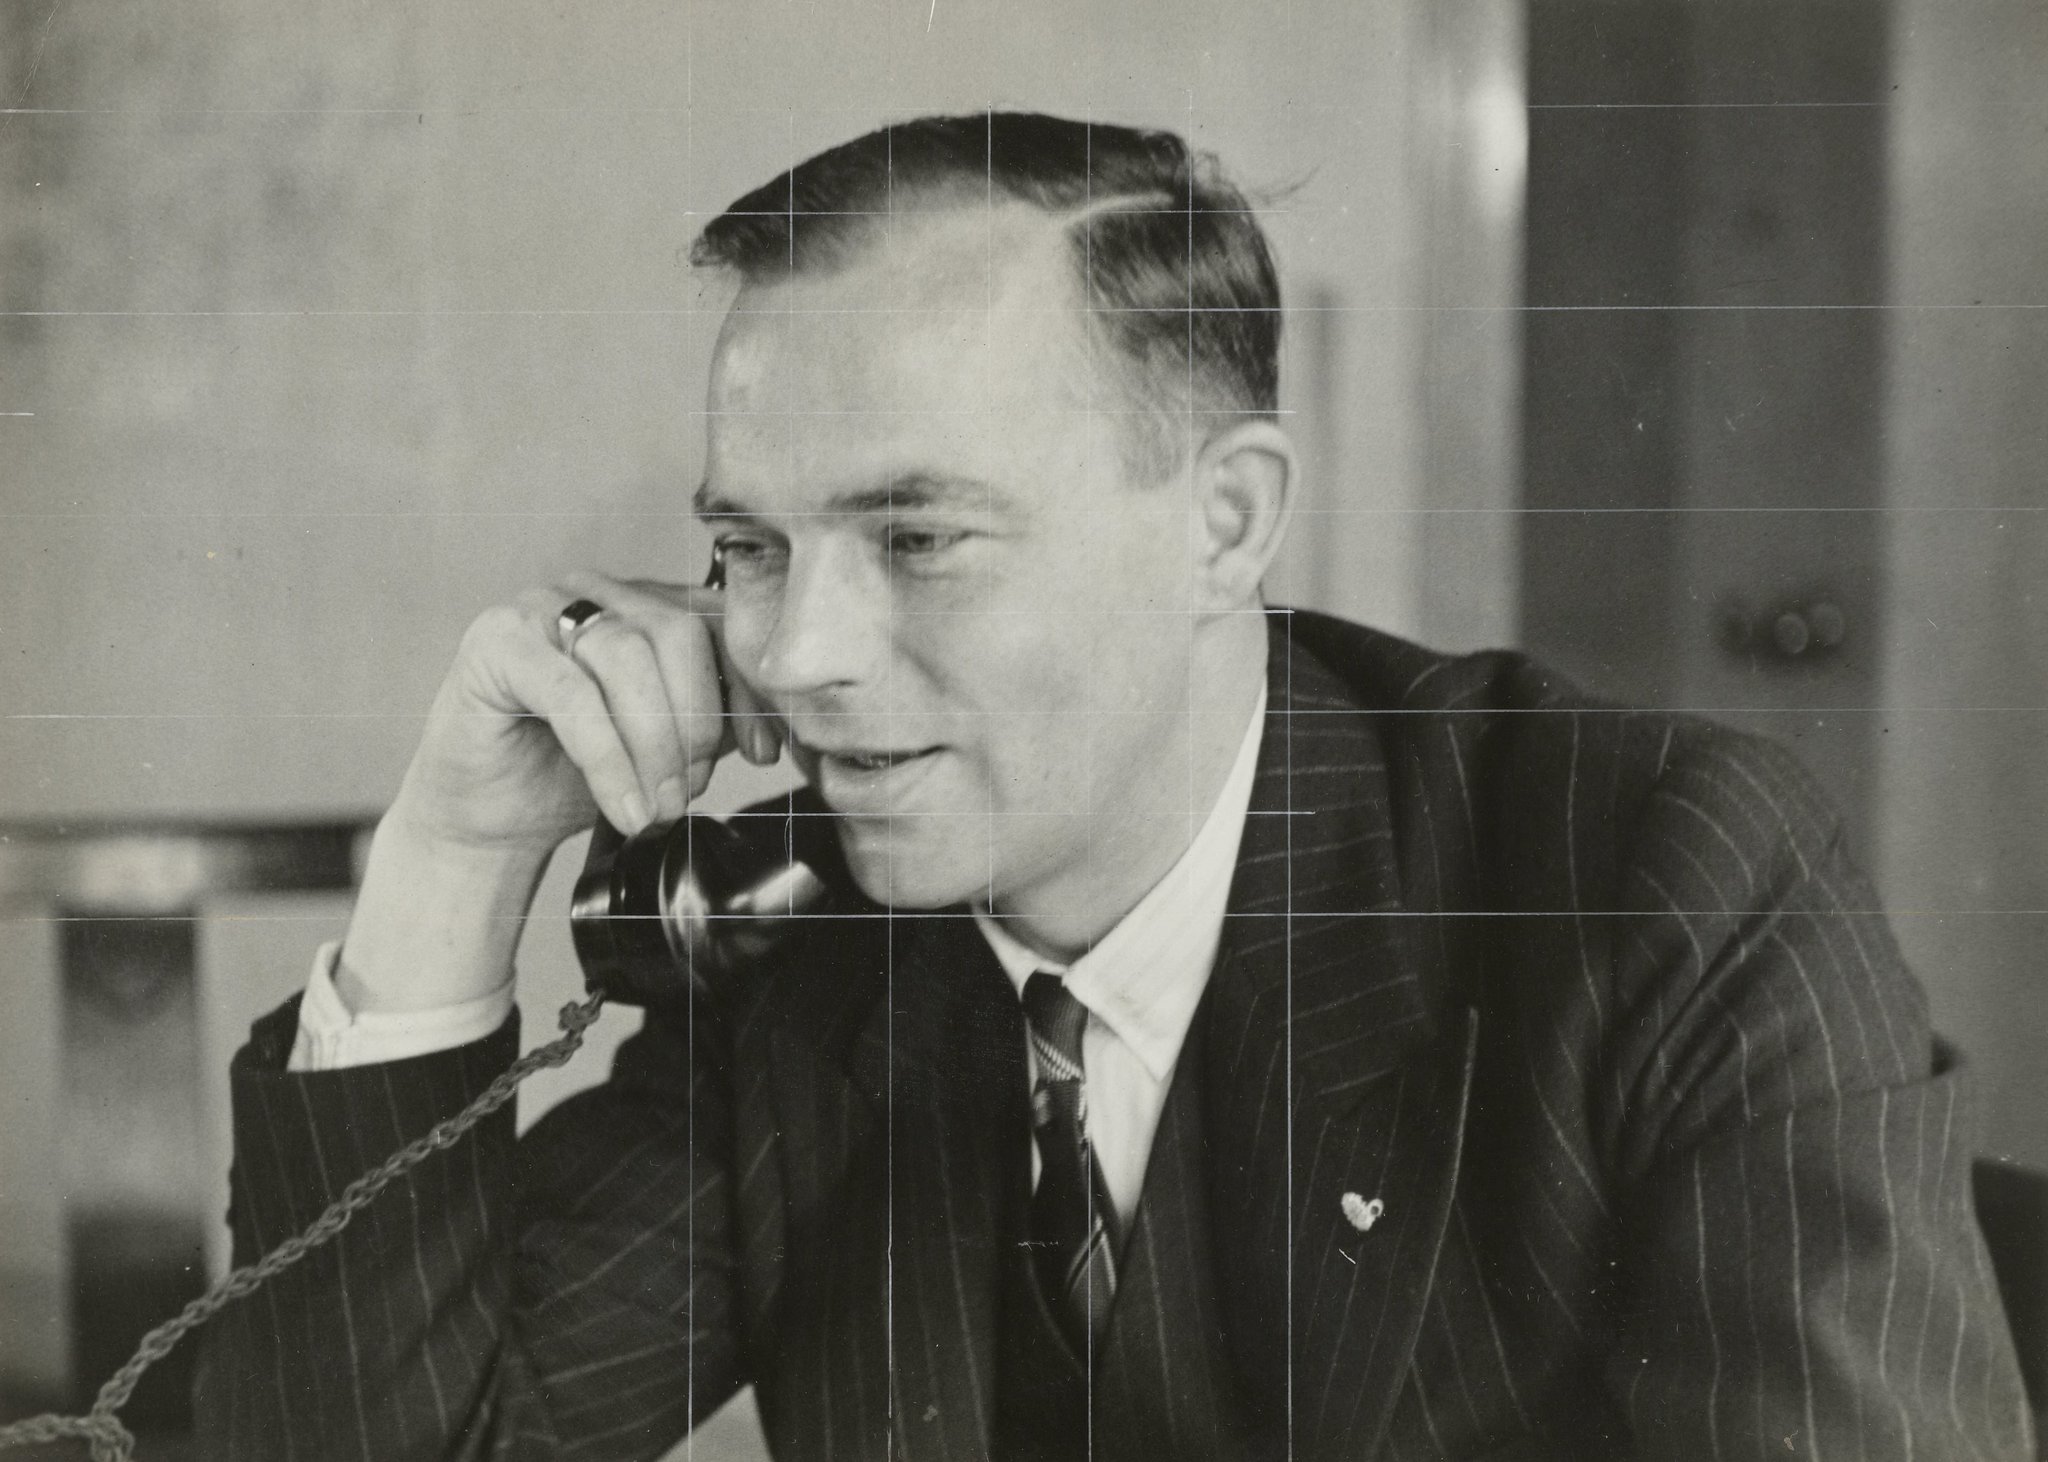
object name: photograph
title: Minister J.A.W. Burger aan de telefoon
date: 1943-1944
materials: photographic support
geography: london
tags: london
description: Jacobus Albertus Wilhelmus (Jaap) Burger (1904-1986) werd in 1944 als Engelandvaarder opgenomen in het kabinet-Gerbrand in Londen. Hij was aanvankelijk een minister zonder portefeuille, belast met het terugkeerbeleid (voorbereiding van het herstel van het bestuur na de bevrijding). Van 31 mei 1944 tot 27 januari 1945 was hij minister van Binnenlandse Zaken. Een conflict met Gerbrandy over de naoorlogse berechting van 'foute' Nederlanders leidde tot zijn aftreden. Het lijnennet op de foto is aangebracht door kunstenaar Cor Visser.